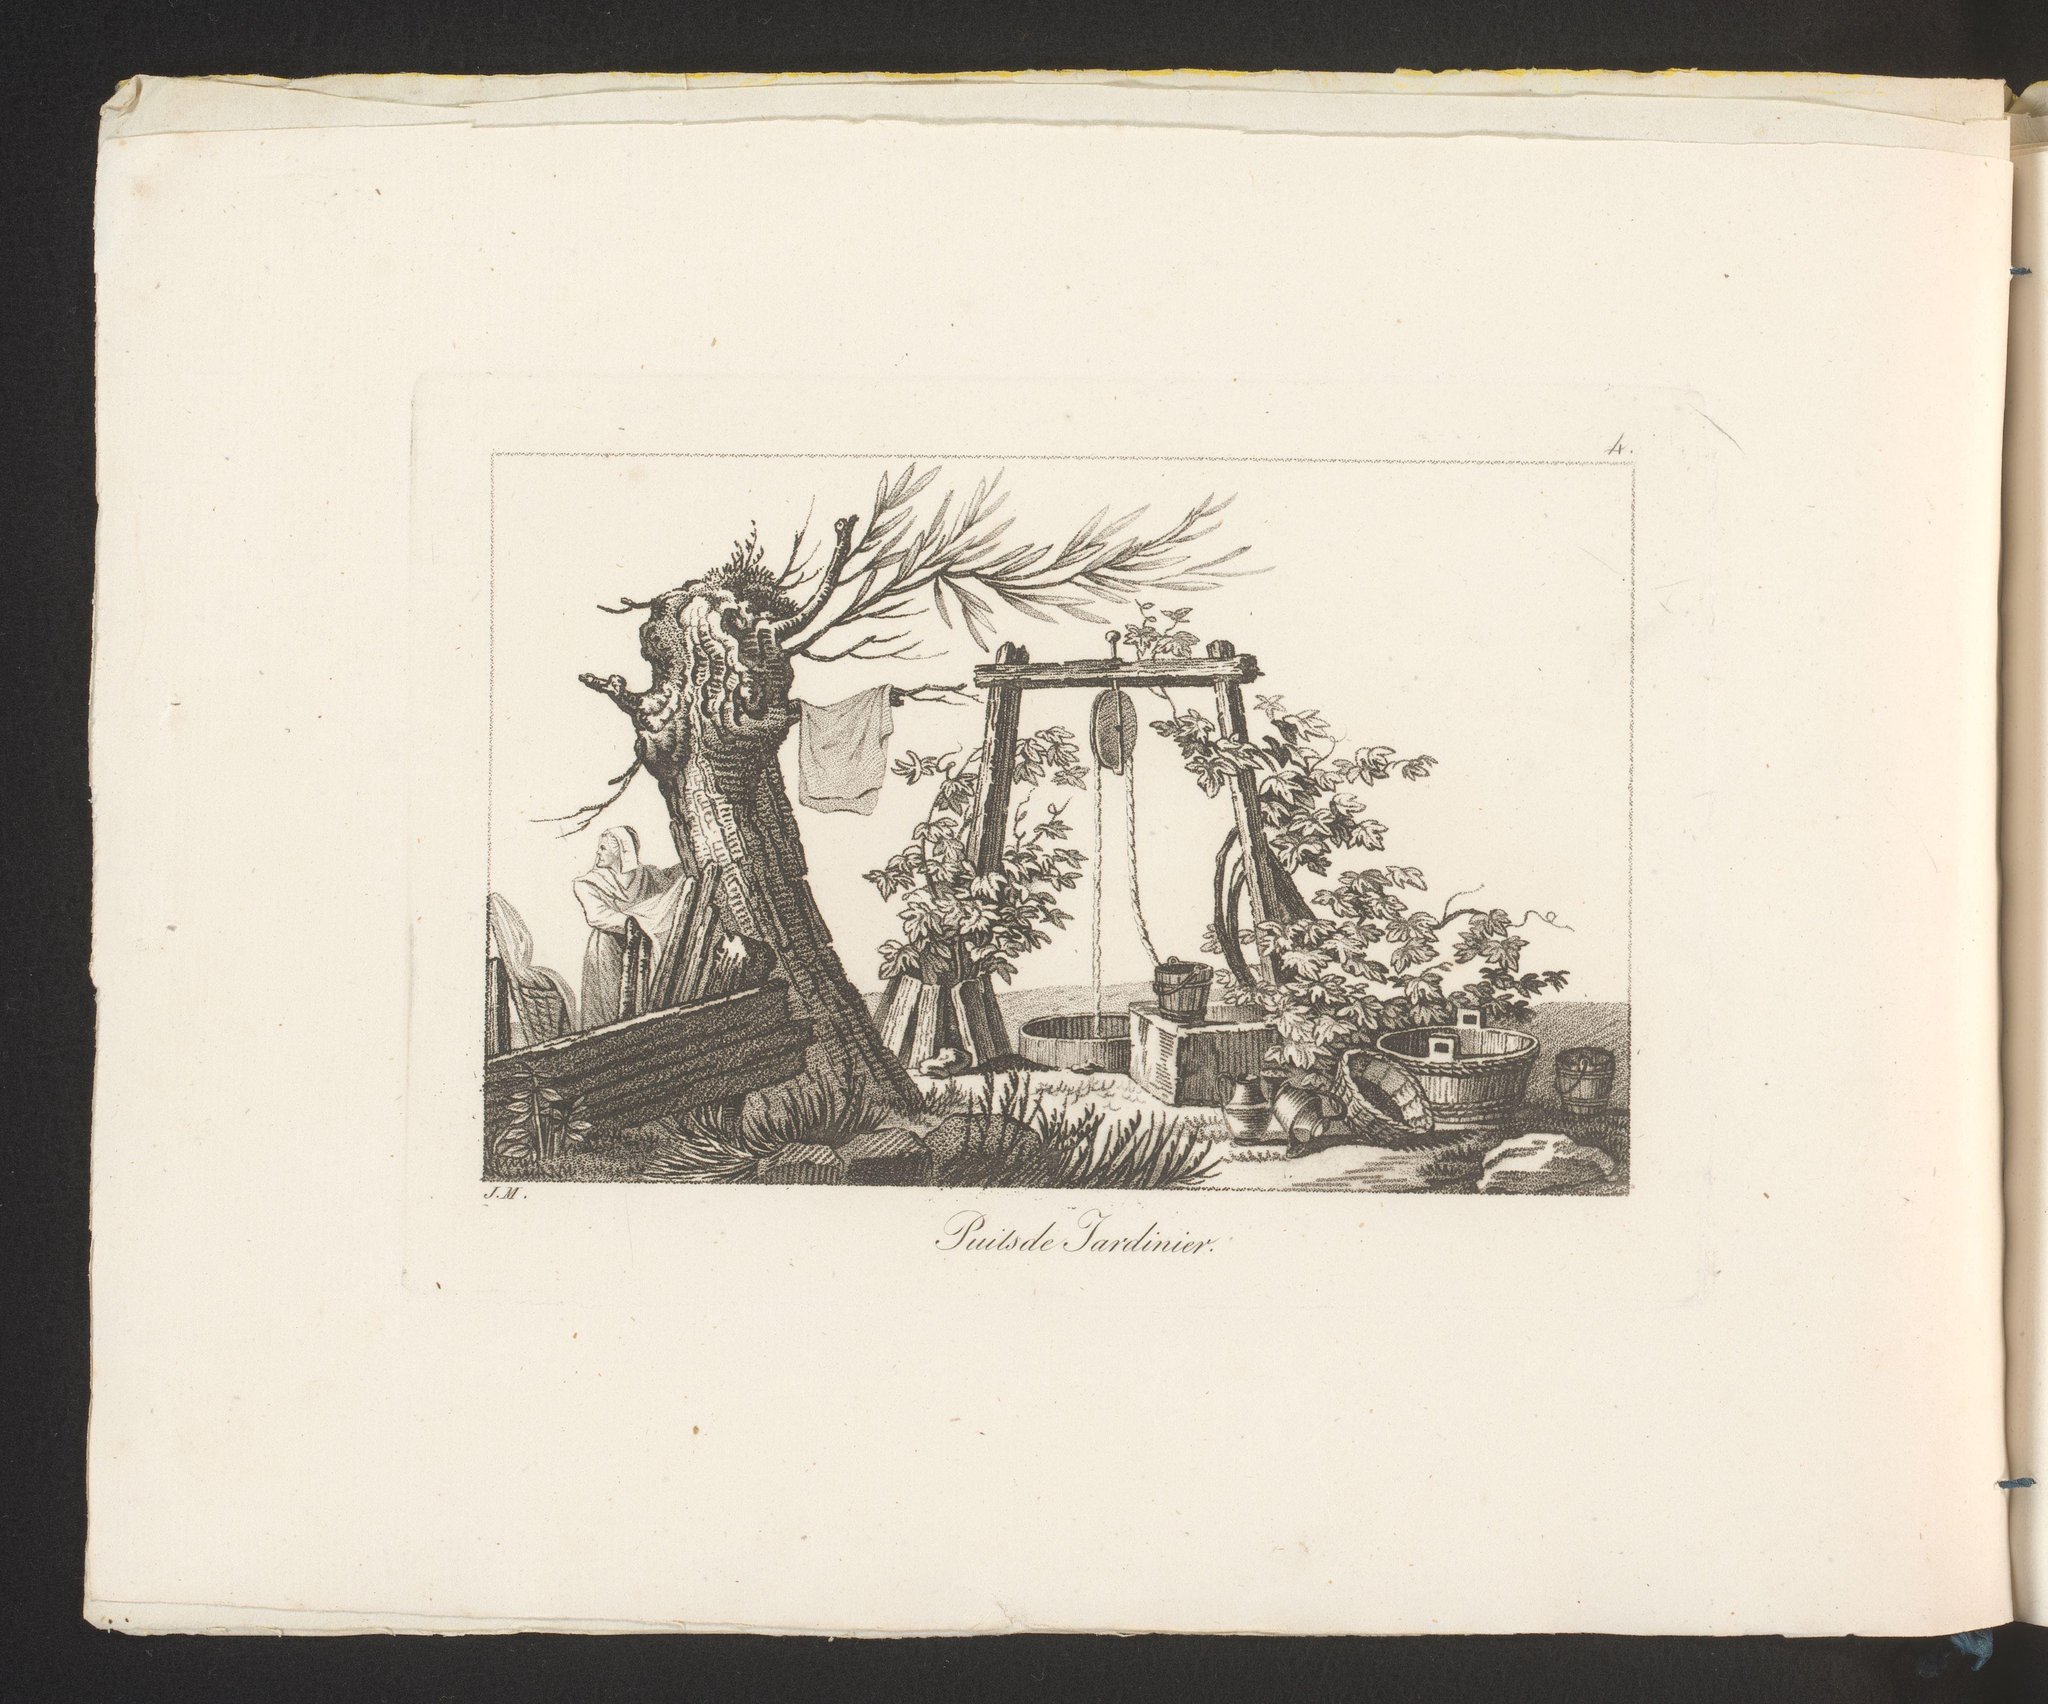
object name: album leaf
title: Ier. cahier petites etudes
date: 1800-1825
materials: paper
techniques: printmaking, engraving, etching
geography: paris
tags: windmill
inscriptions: collector's mark: Lugt 2760, collector's mark: Lugt 2228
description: Deze prent maakt deel uit van een album.